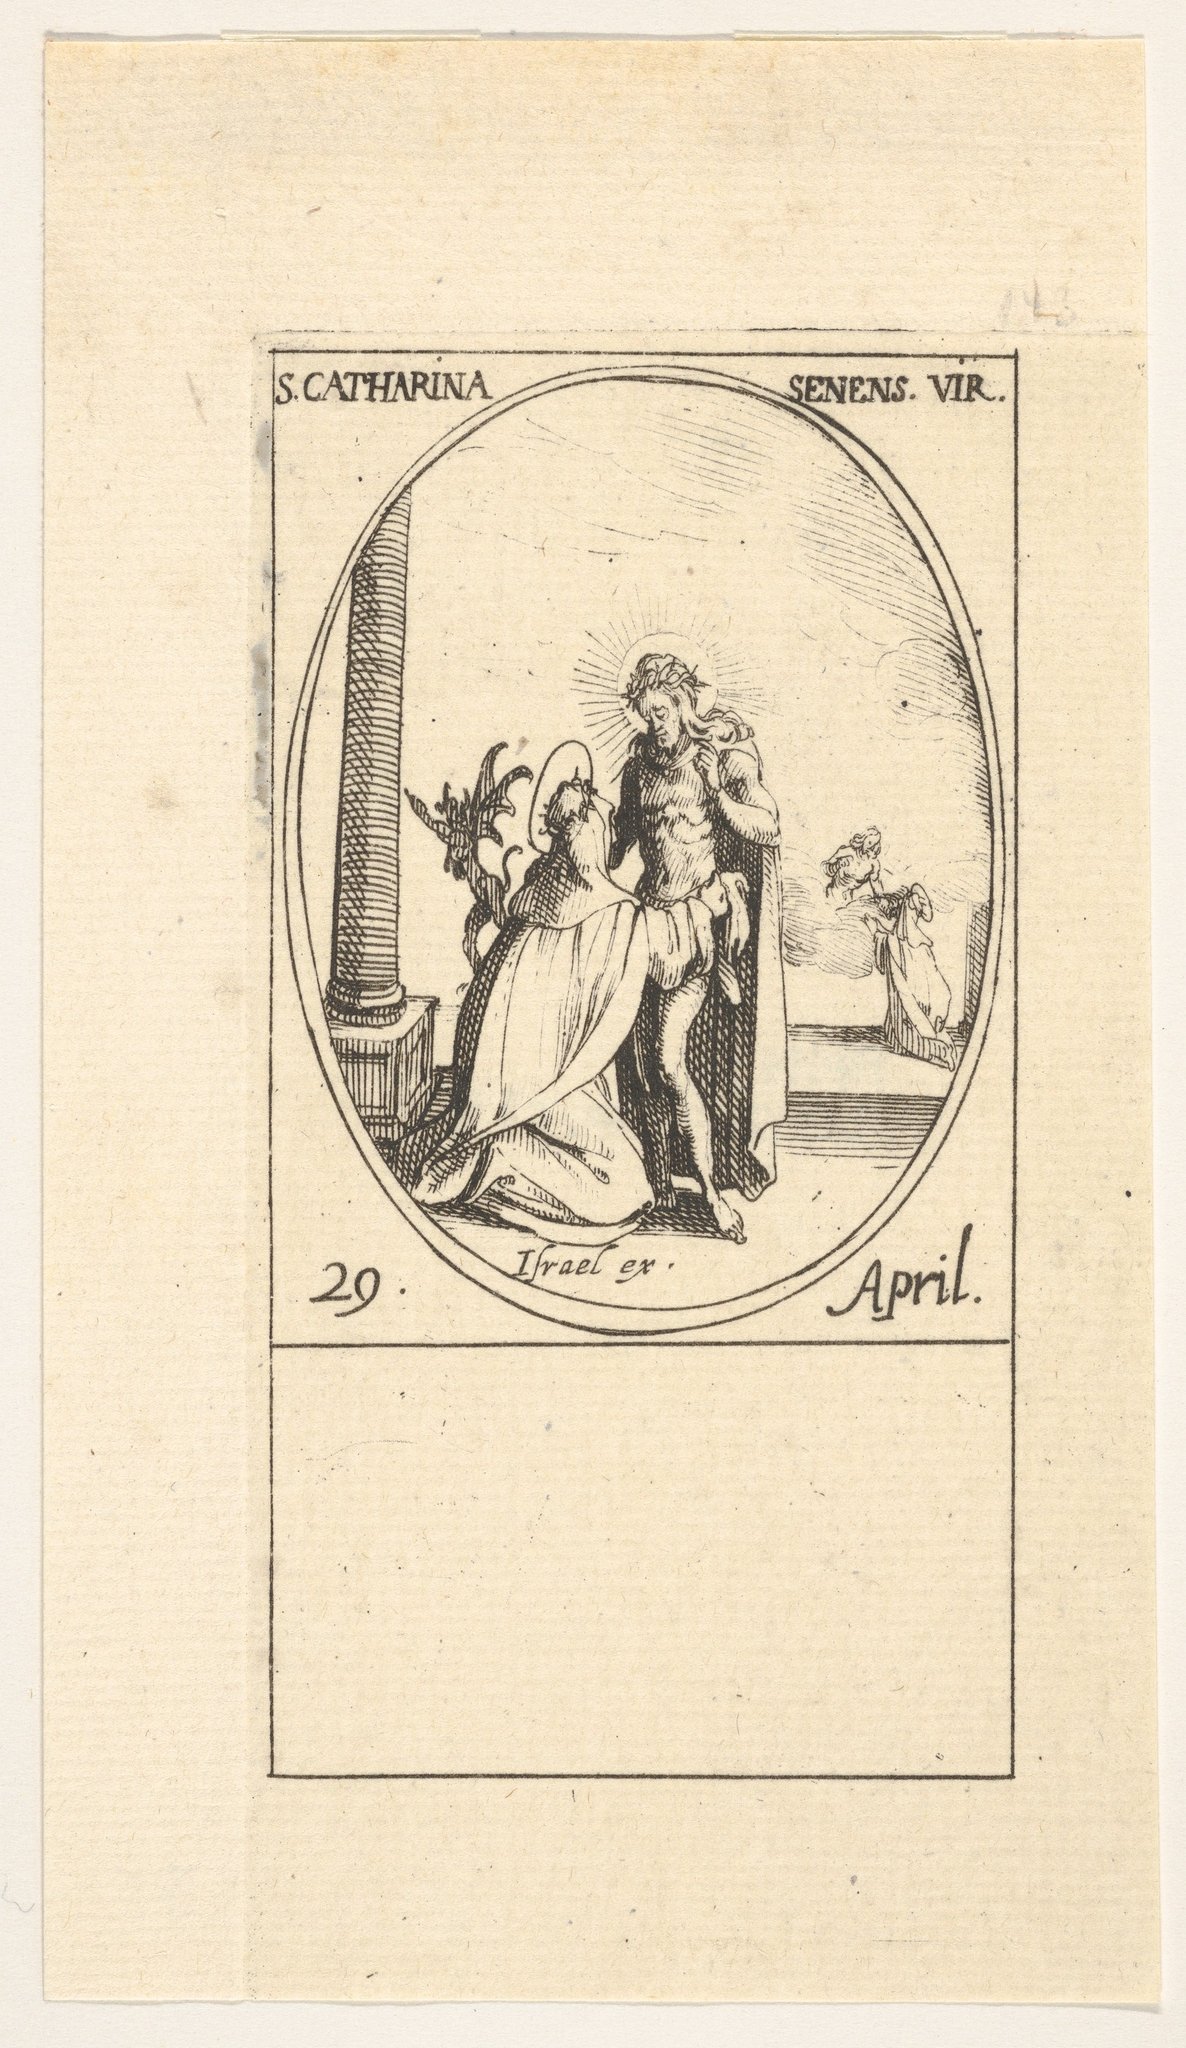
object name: print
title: Vision of Saint Catherine, an oval composition, from "Les images de tous les saints et saintes de l'année" (Images of all the saints of the year)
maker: jacques callot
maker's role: artist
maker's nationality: french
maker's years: 1592-1635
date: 1632-1635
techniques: etching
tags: christ,saint catherine